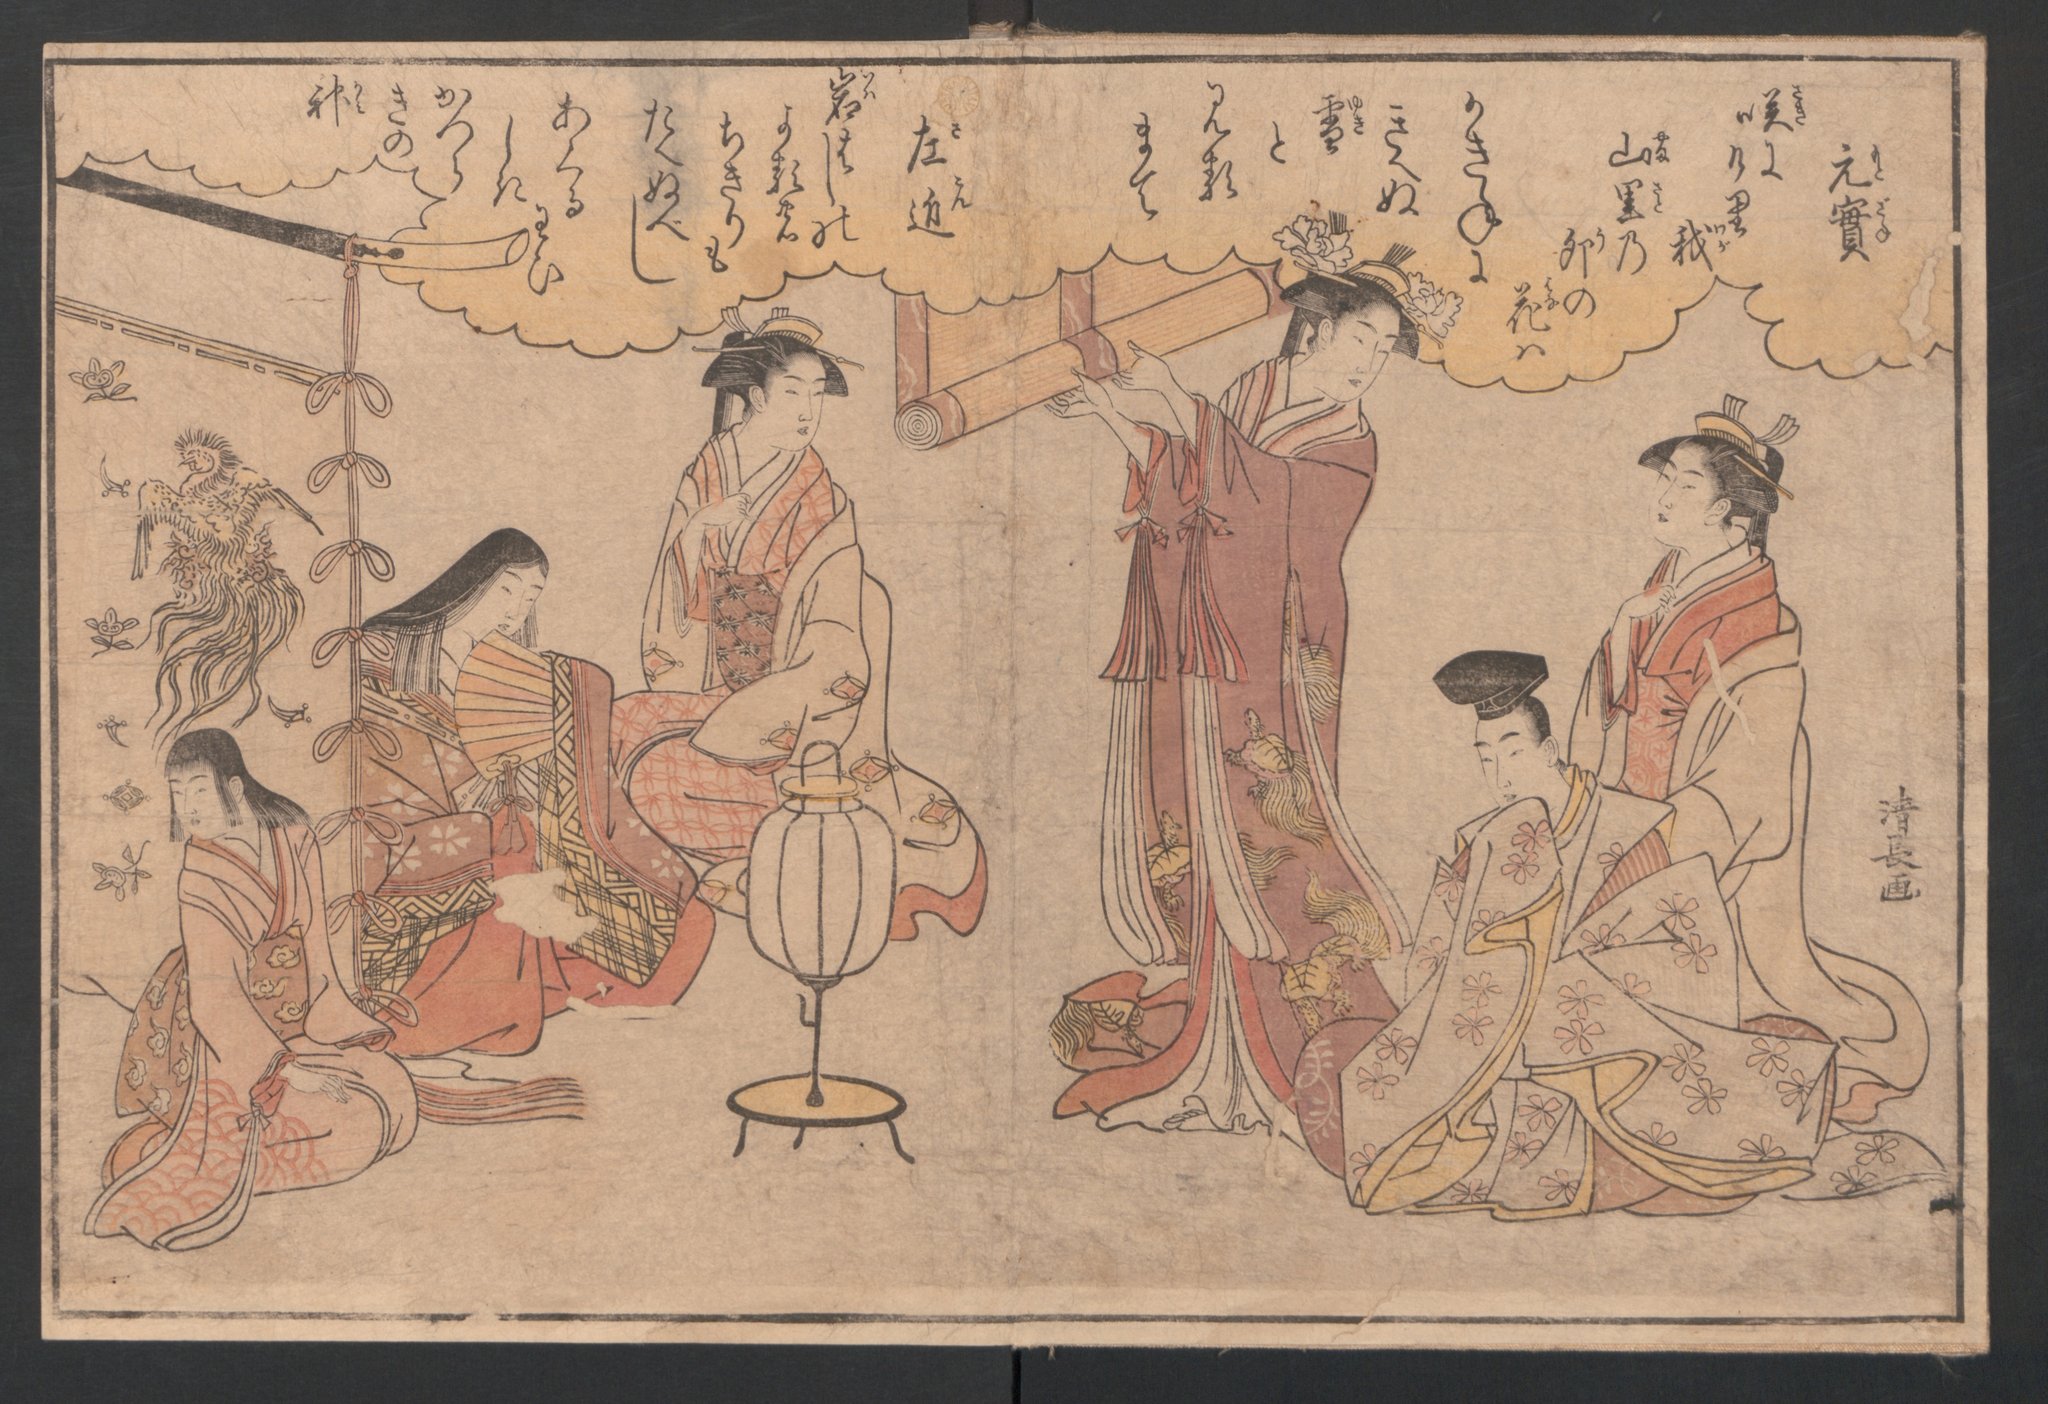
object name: illustrated book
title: Twenty-four Illustrations of Poems of the Thirty-six Poets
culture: japanese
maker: torii kiyonaga 鳥居清長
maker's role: artist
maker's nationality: japanese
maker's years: 1752-1815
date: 1790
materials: ink, paper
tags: poetry,women